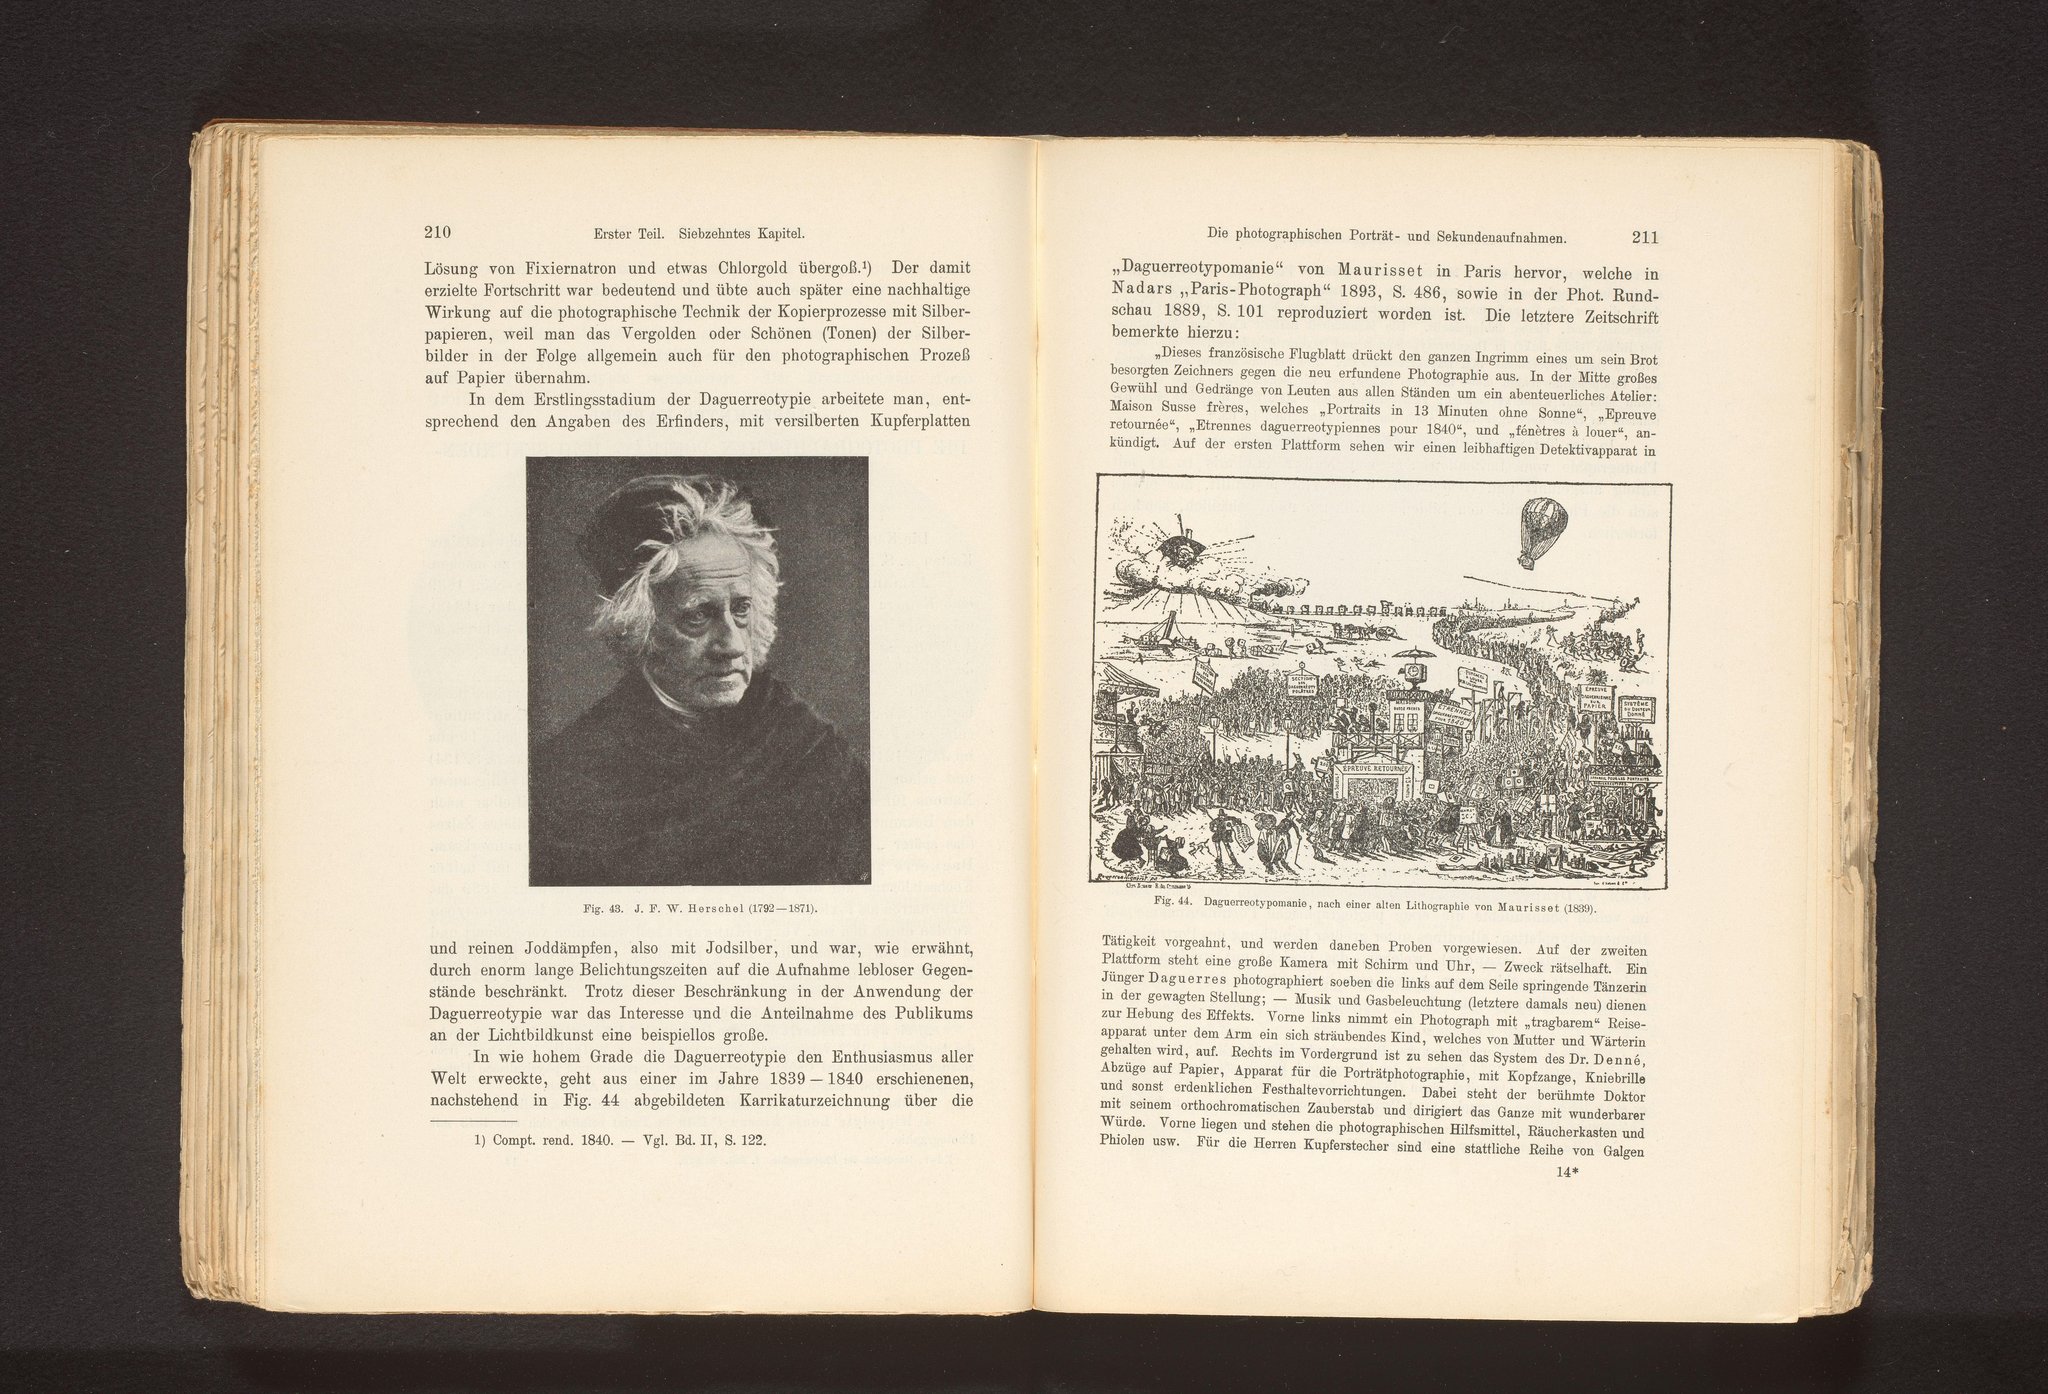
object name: photomechanical print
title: Portret van John Herschel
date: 1900-1905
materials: paper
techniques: autotype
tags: astronomy (and cosmography)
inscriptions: number: ‘Fig. 43.’